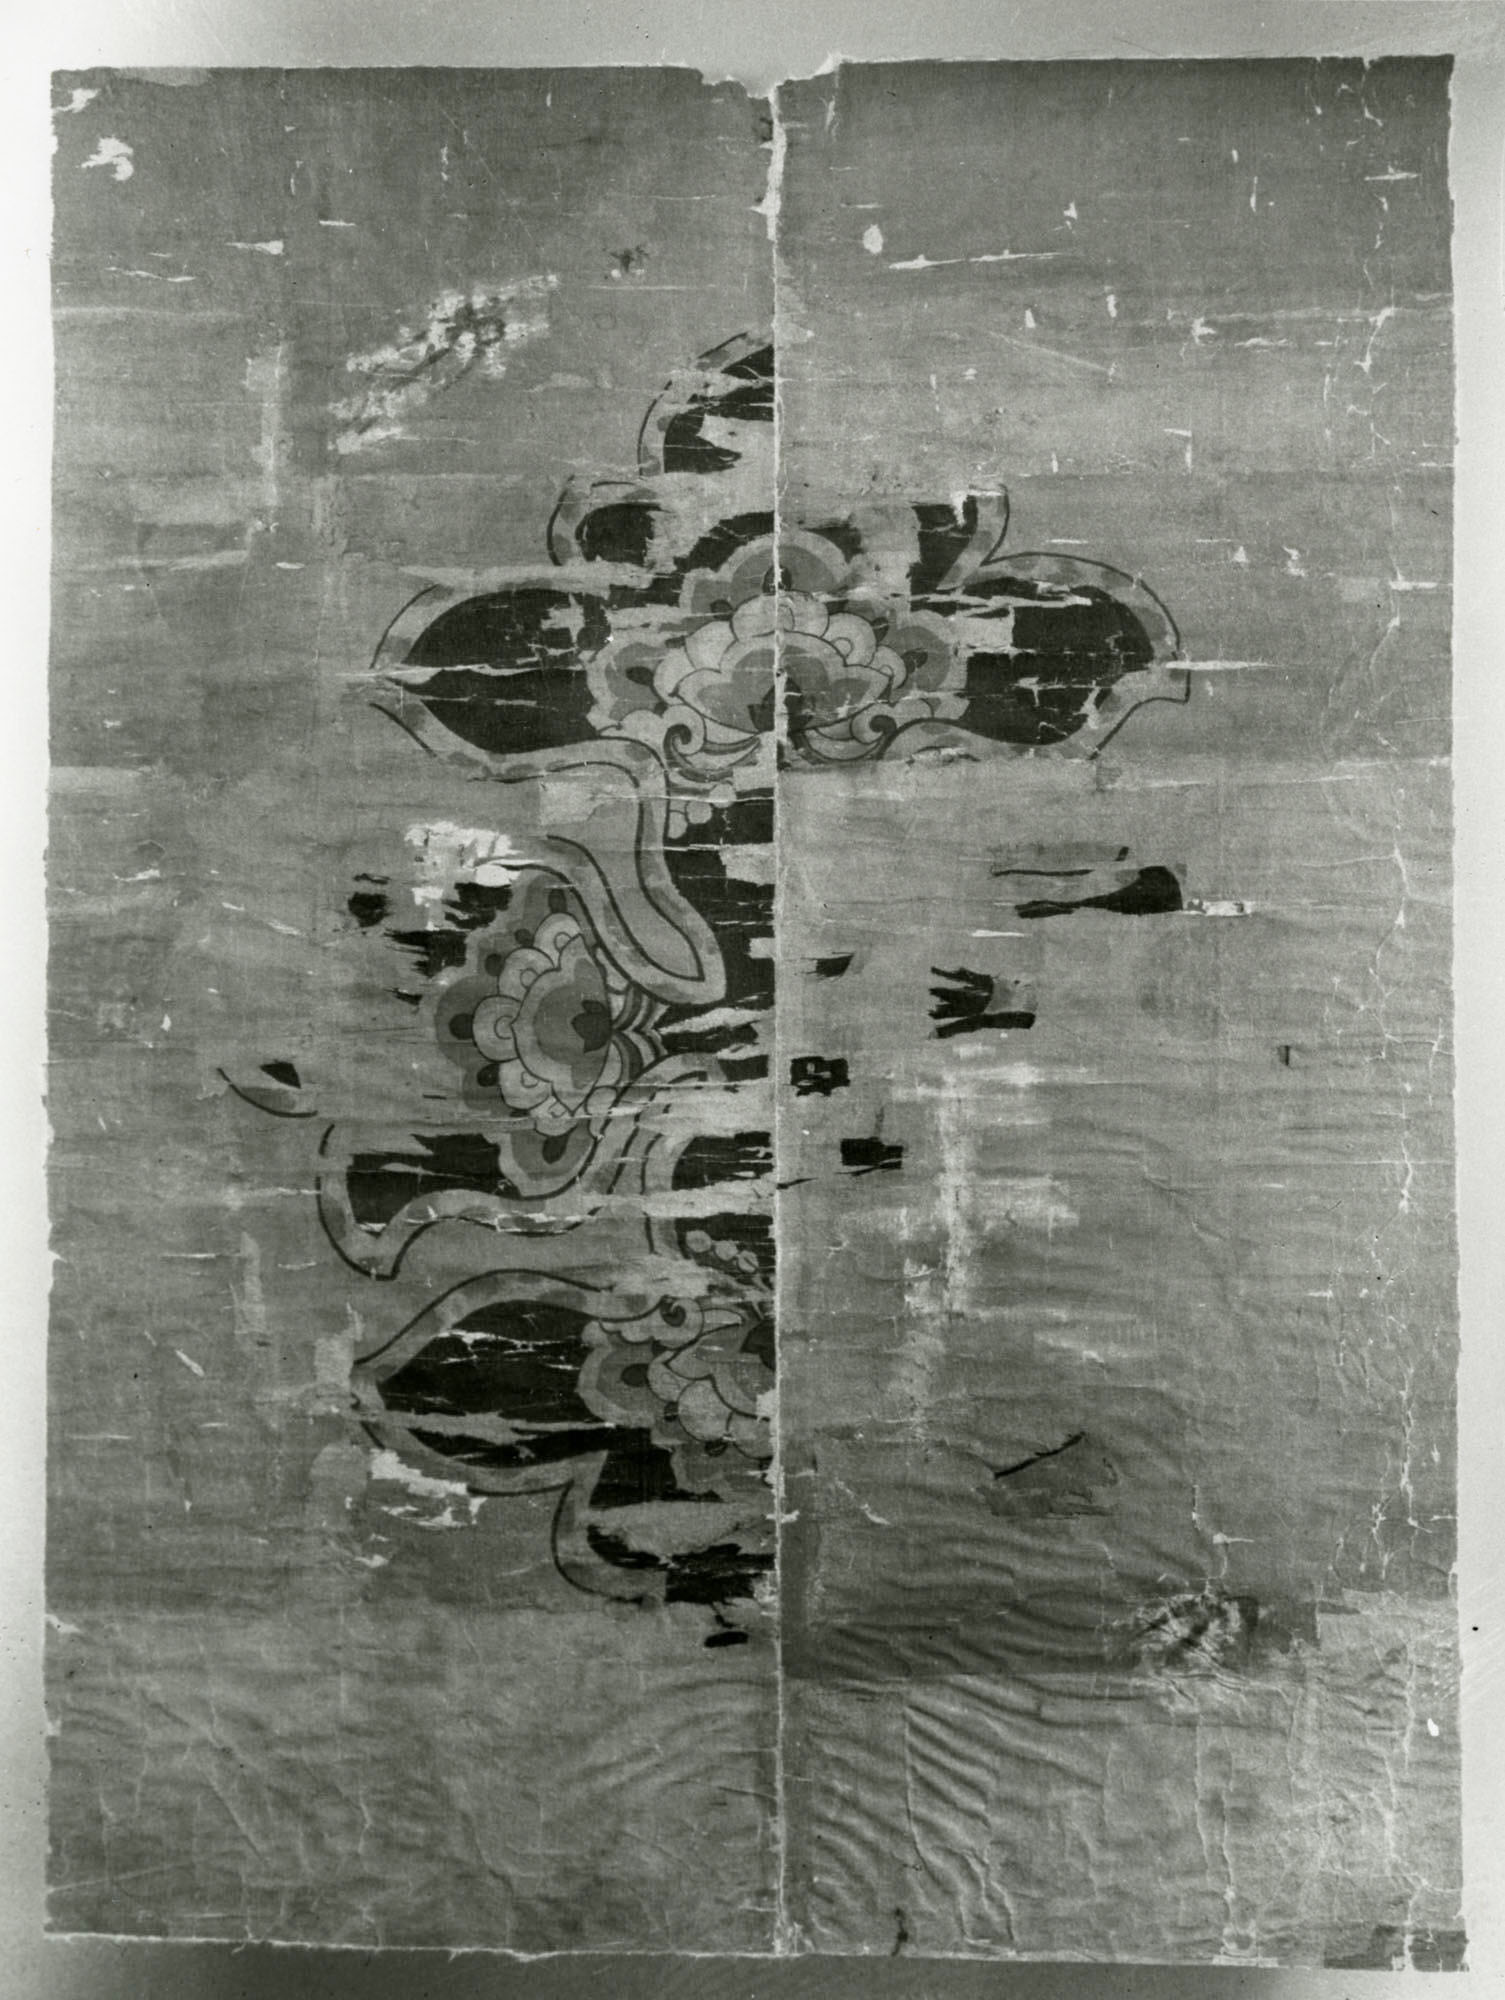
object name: painted cloth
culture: chinese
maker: unidentified artist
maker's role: artist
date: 1701-1800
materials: ink, silk